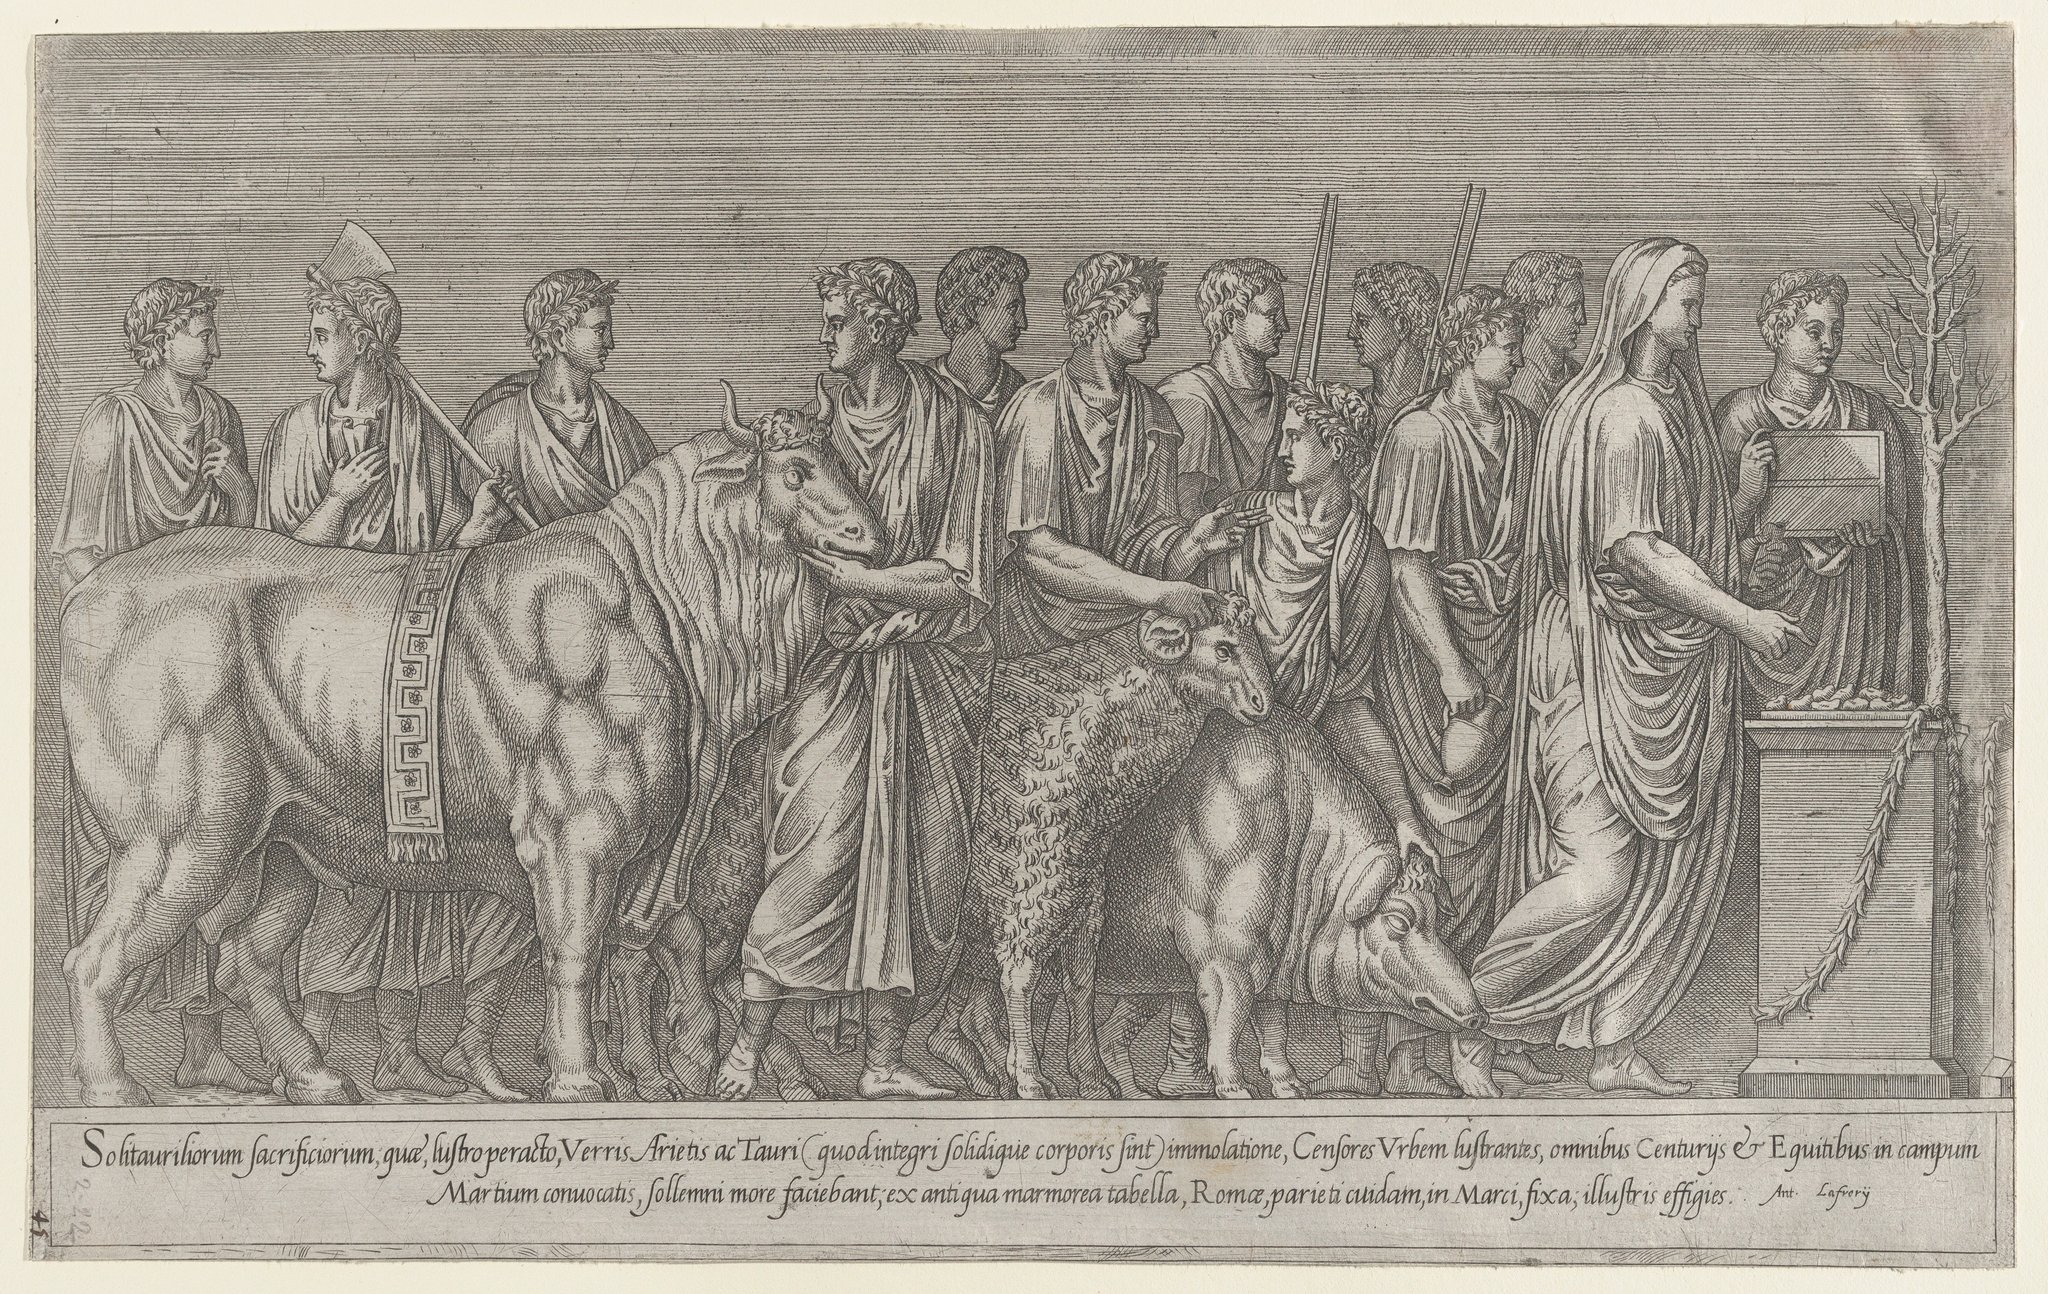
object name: print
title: Sacrifice on the Campus Martius, from "Speculum Romanae Magnificentiae"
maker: Anonymous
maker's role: artist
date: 1501-1600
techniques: engraving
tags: animals,men,women,axes